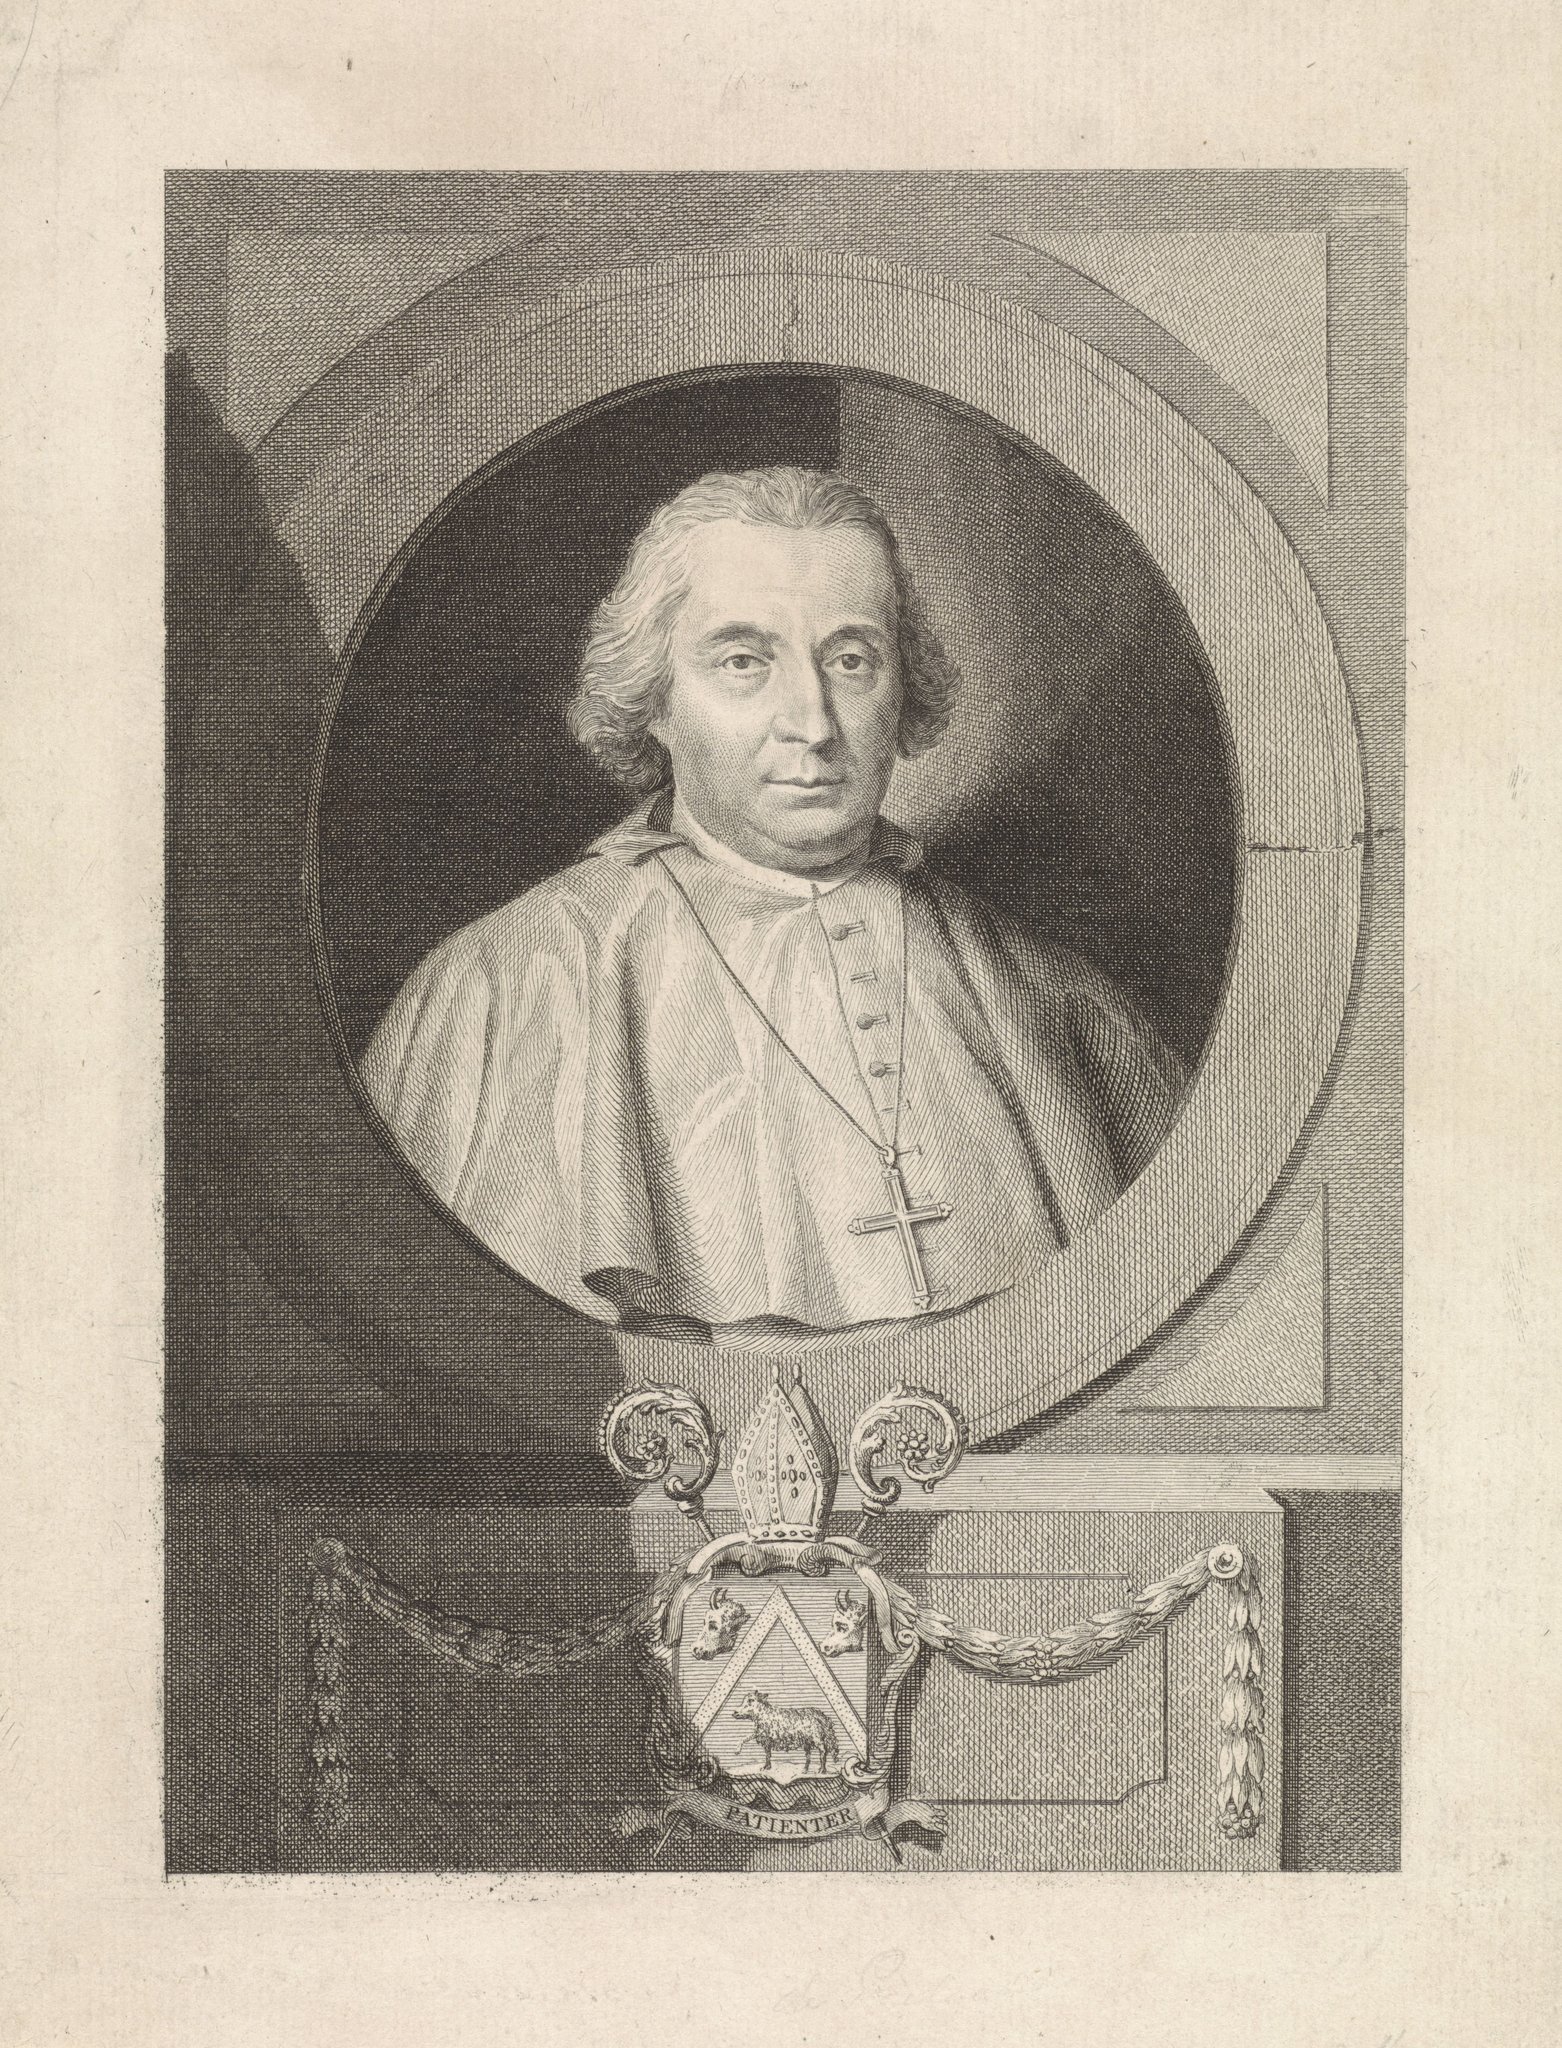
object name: print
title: Portret van Godfried Hermans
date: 1780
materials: paper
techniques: etching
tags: haaren, abt, godfried hermans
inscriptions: collector's mark: Lugt 2228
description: Portret van Godfried Hermans, abt van Tongerloo.